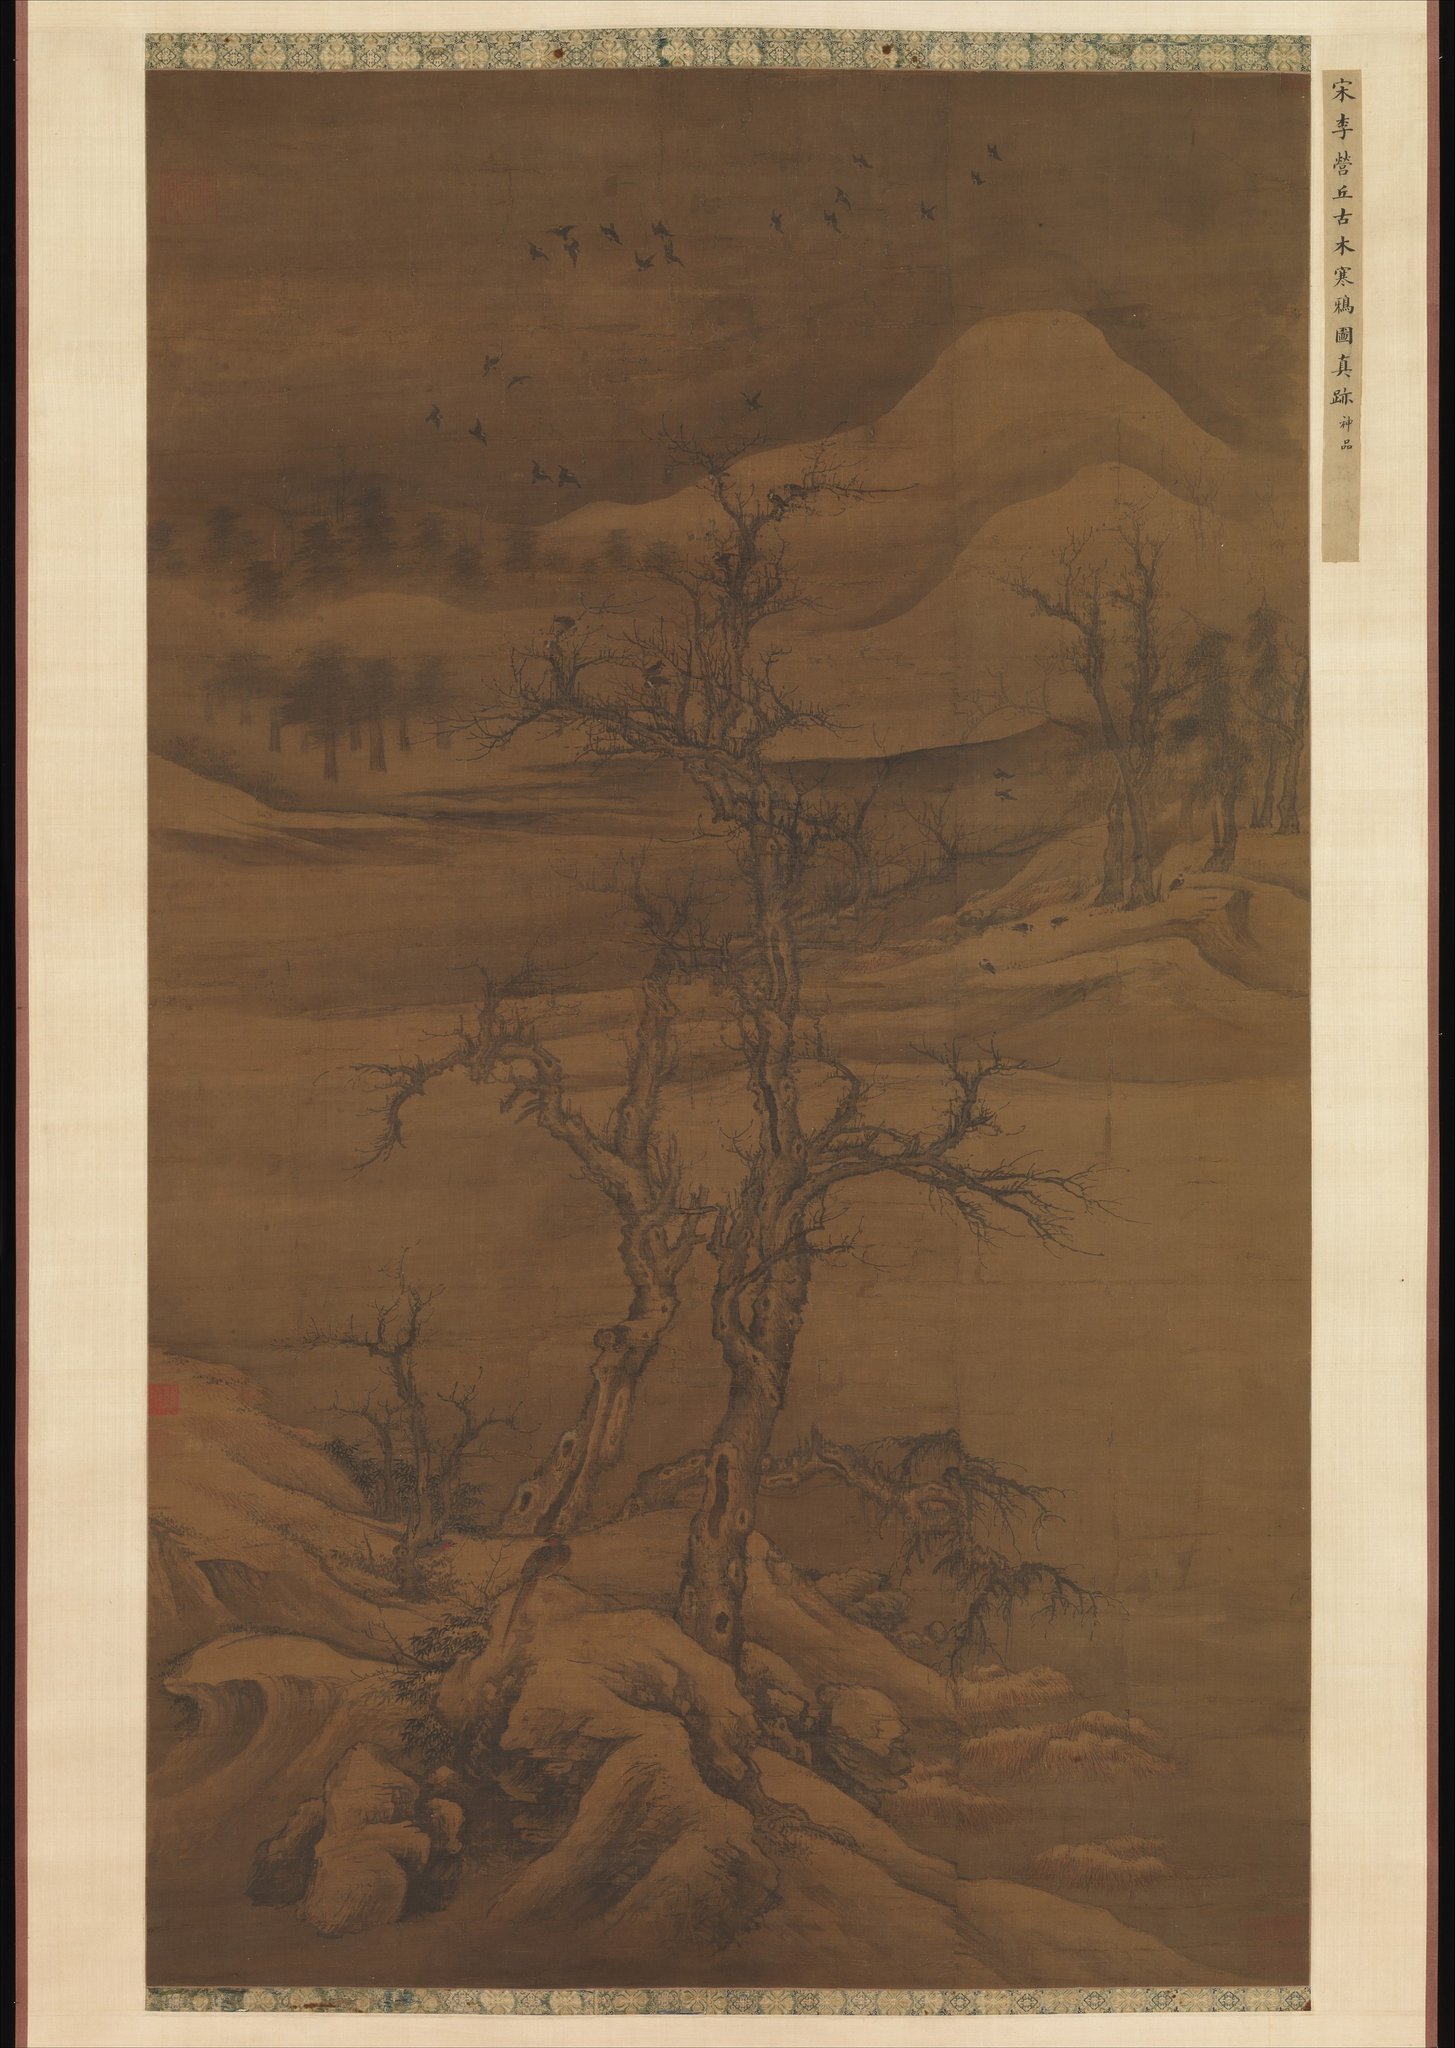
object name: hanging scroll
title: Crows in Old Trees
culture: chinese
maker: luo zhichuan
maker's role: artist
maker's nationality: chinese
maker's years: 1290-1340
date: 1301-1333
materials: ink, silk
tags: birds,trees